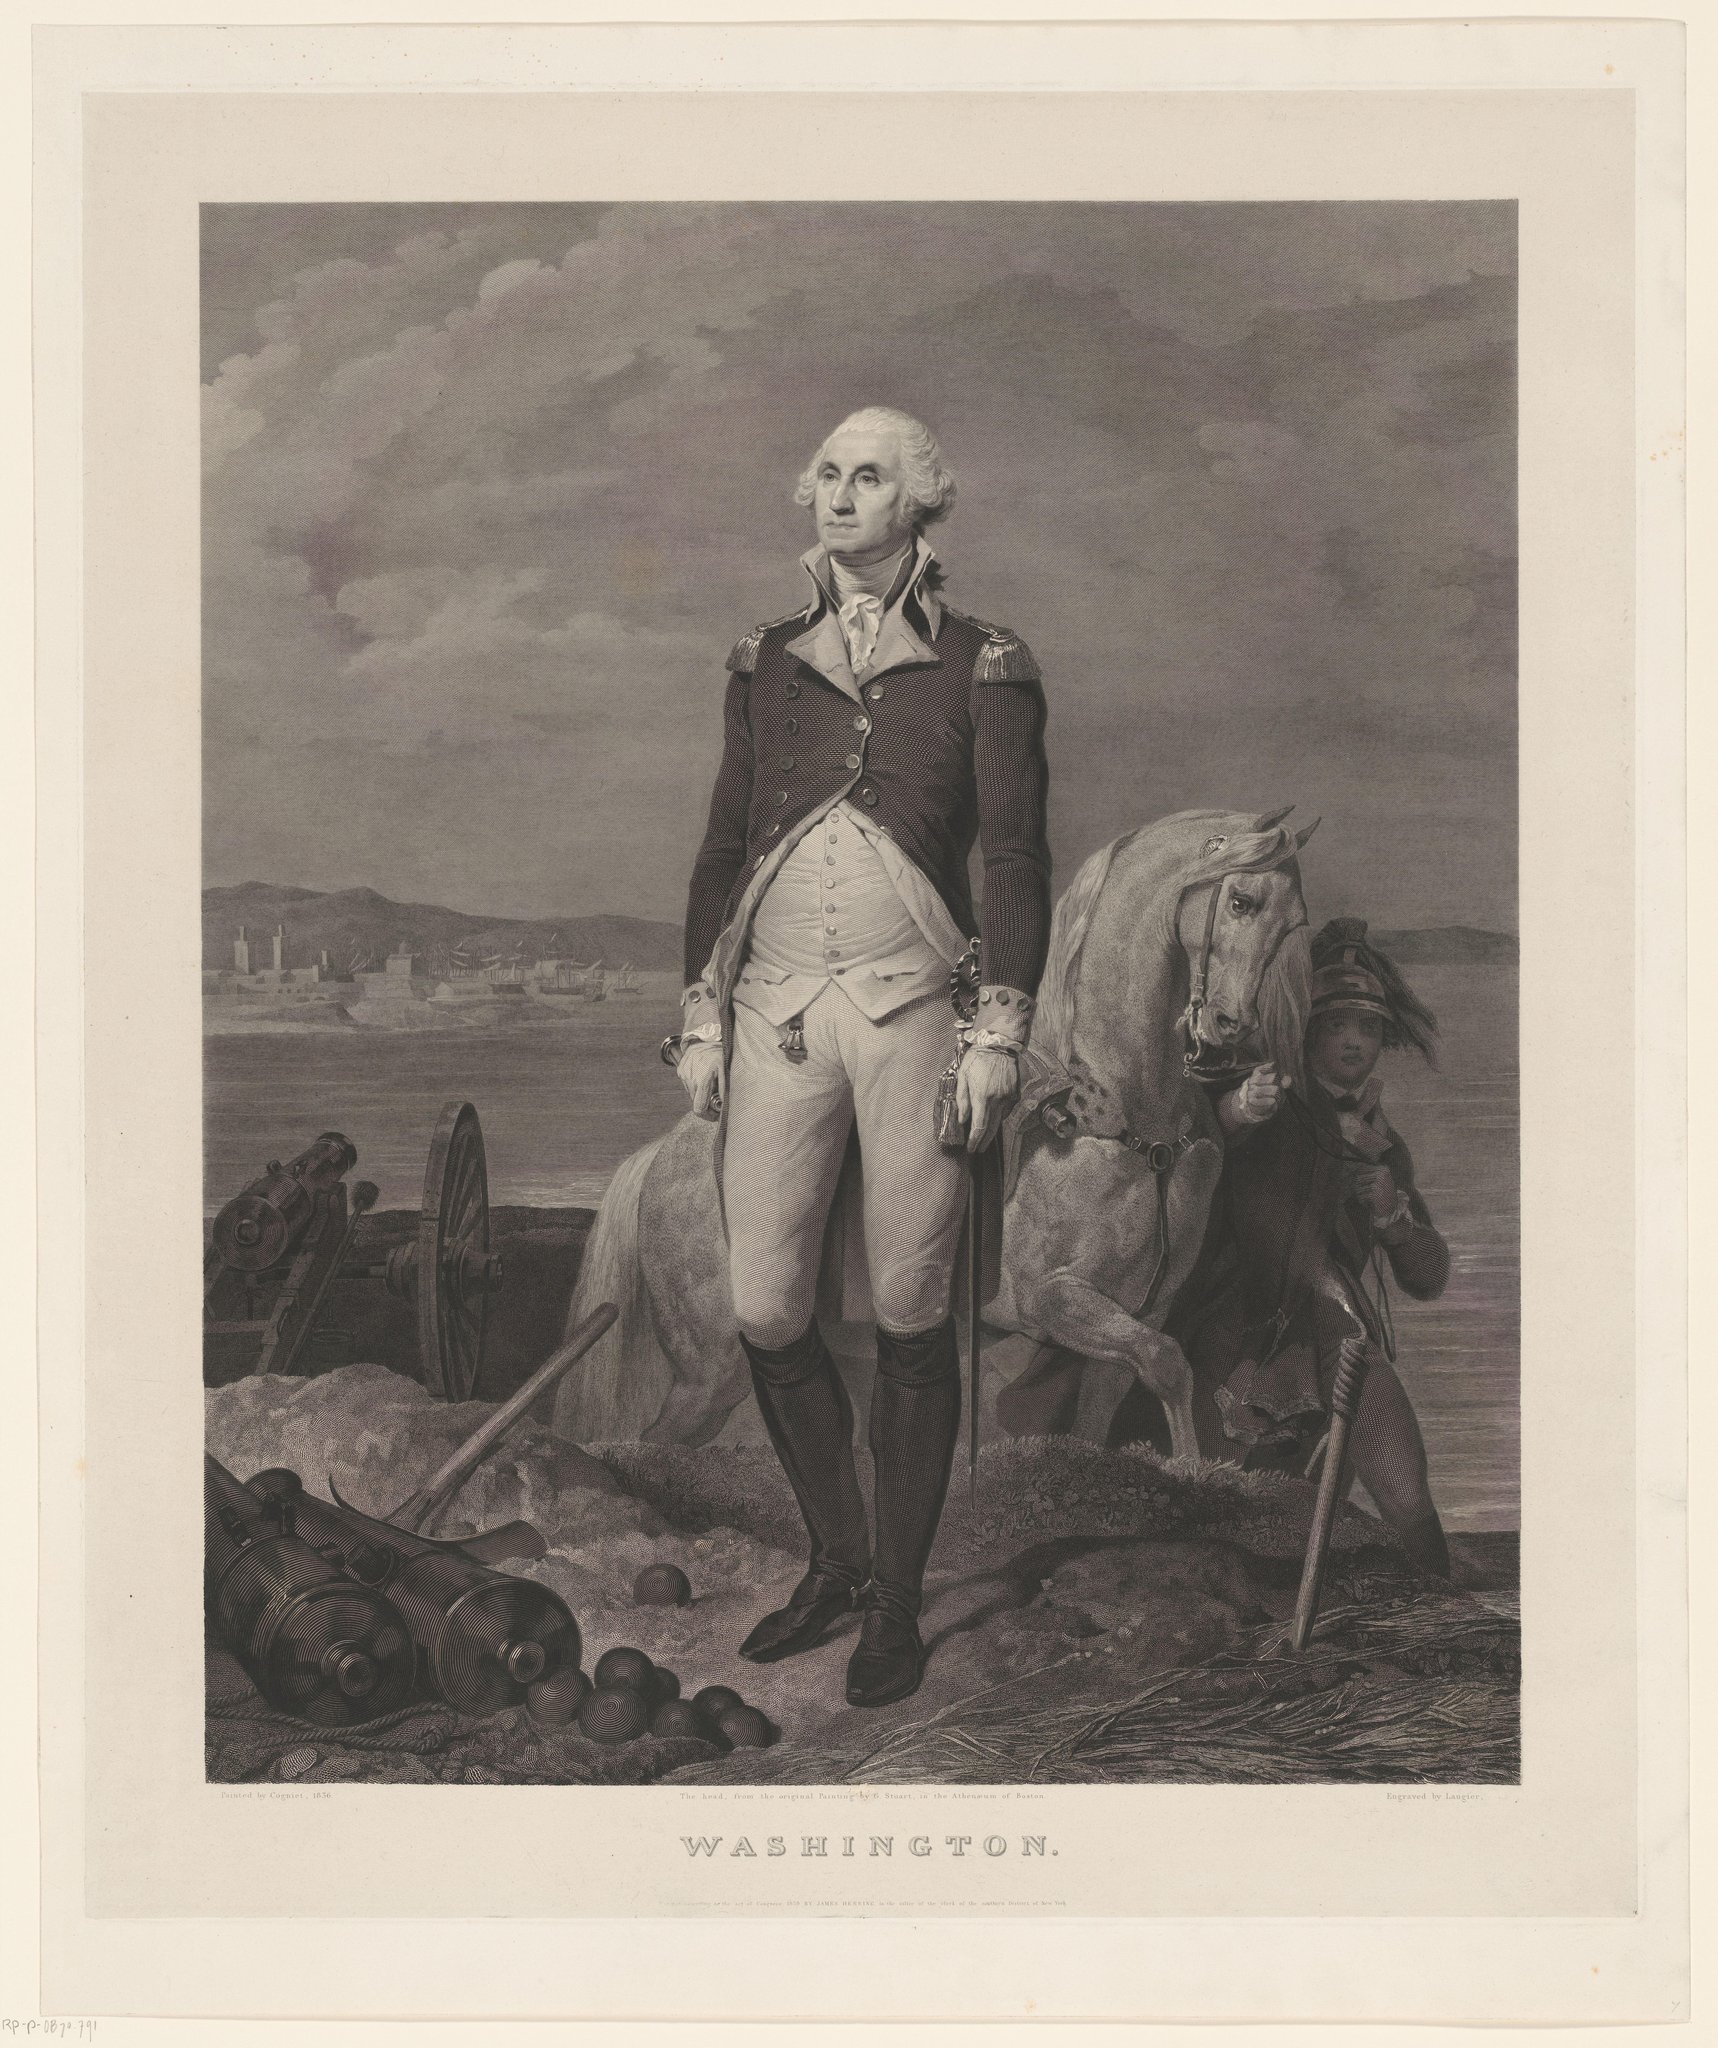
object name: print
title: George Washington en een ruiter met zijn paard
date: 1839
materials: paper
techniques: engraving, etching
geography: paris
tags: historical persons, horse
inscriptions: collector's mark: Lugt 12